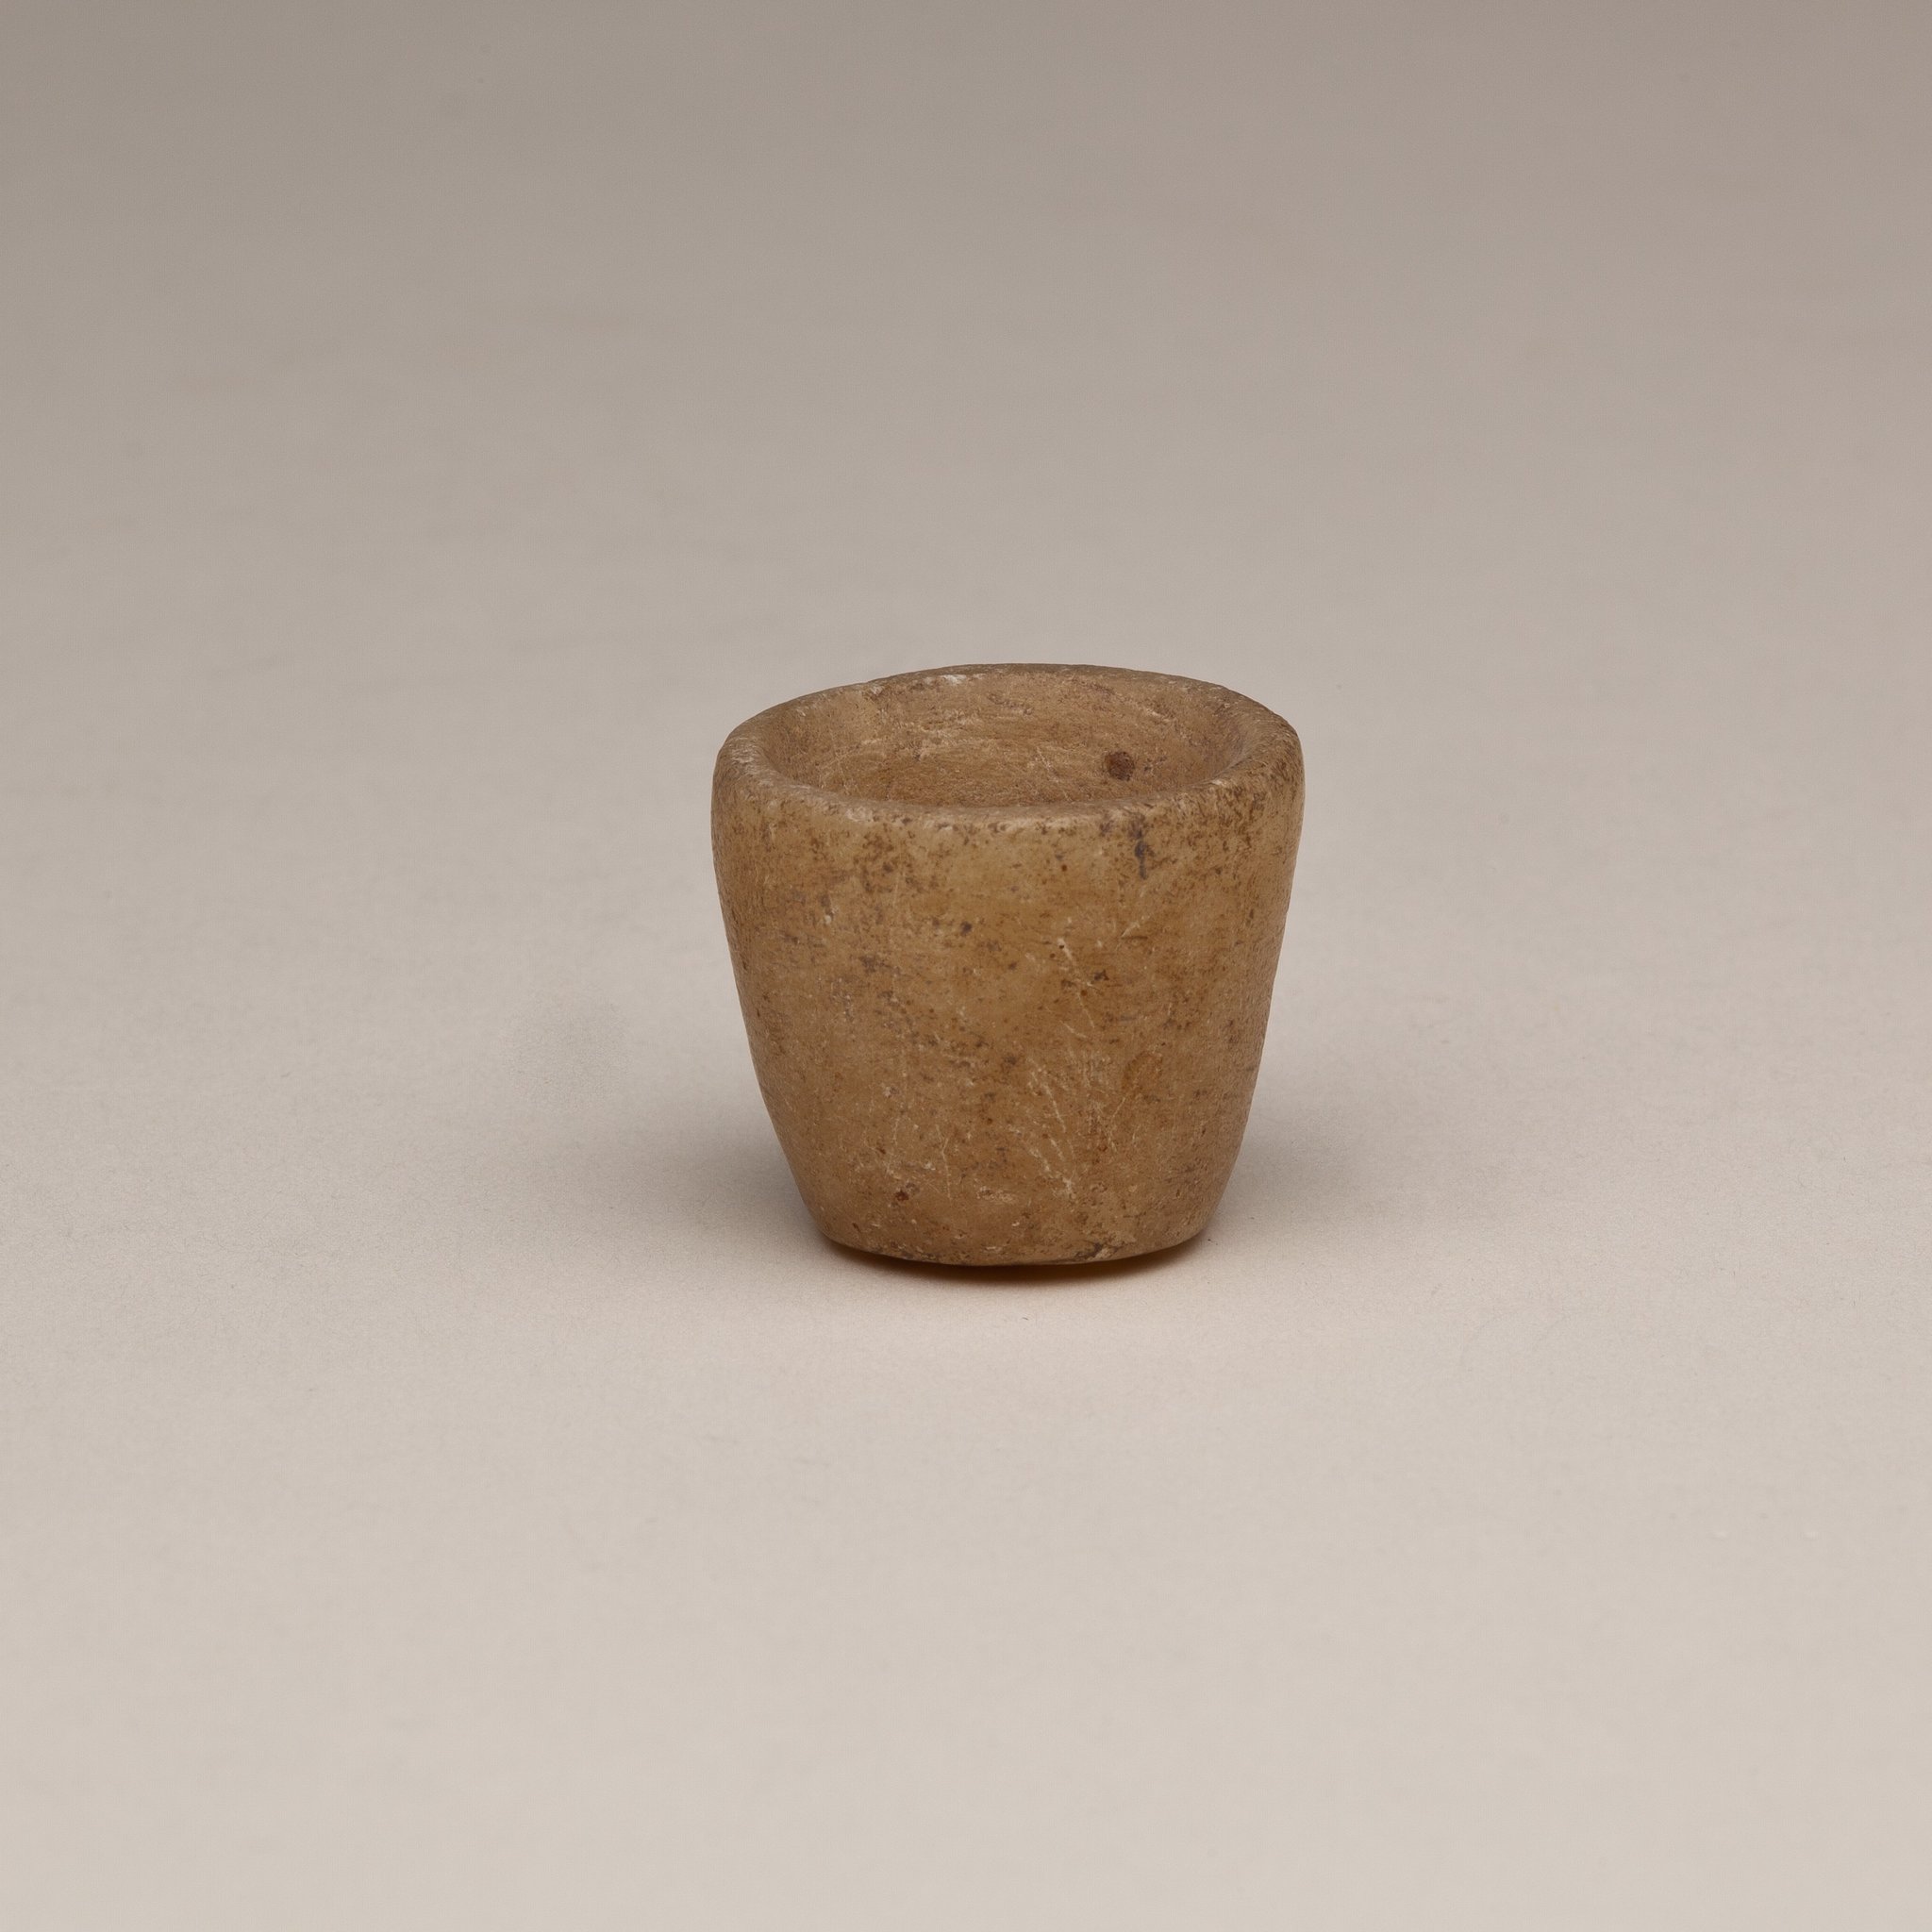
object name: toilet cup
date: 1981-1640 BCE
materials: stone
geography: egypt